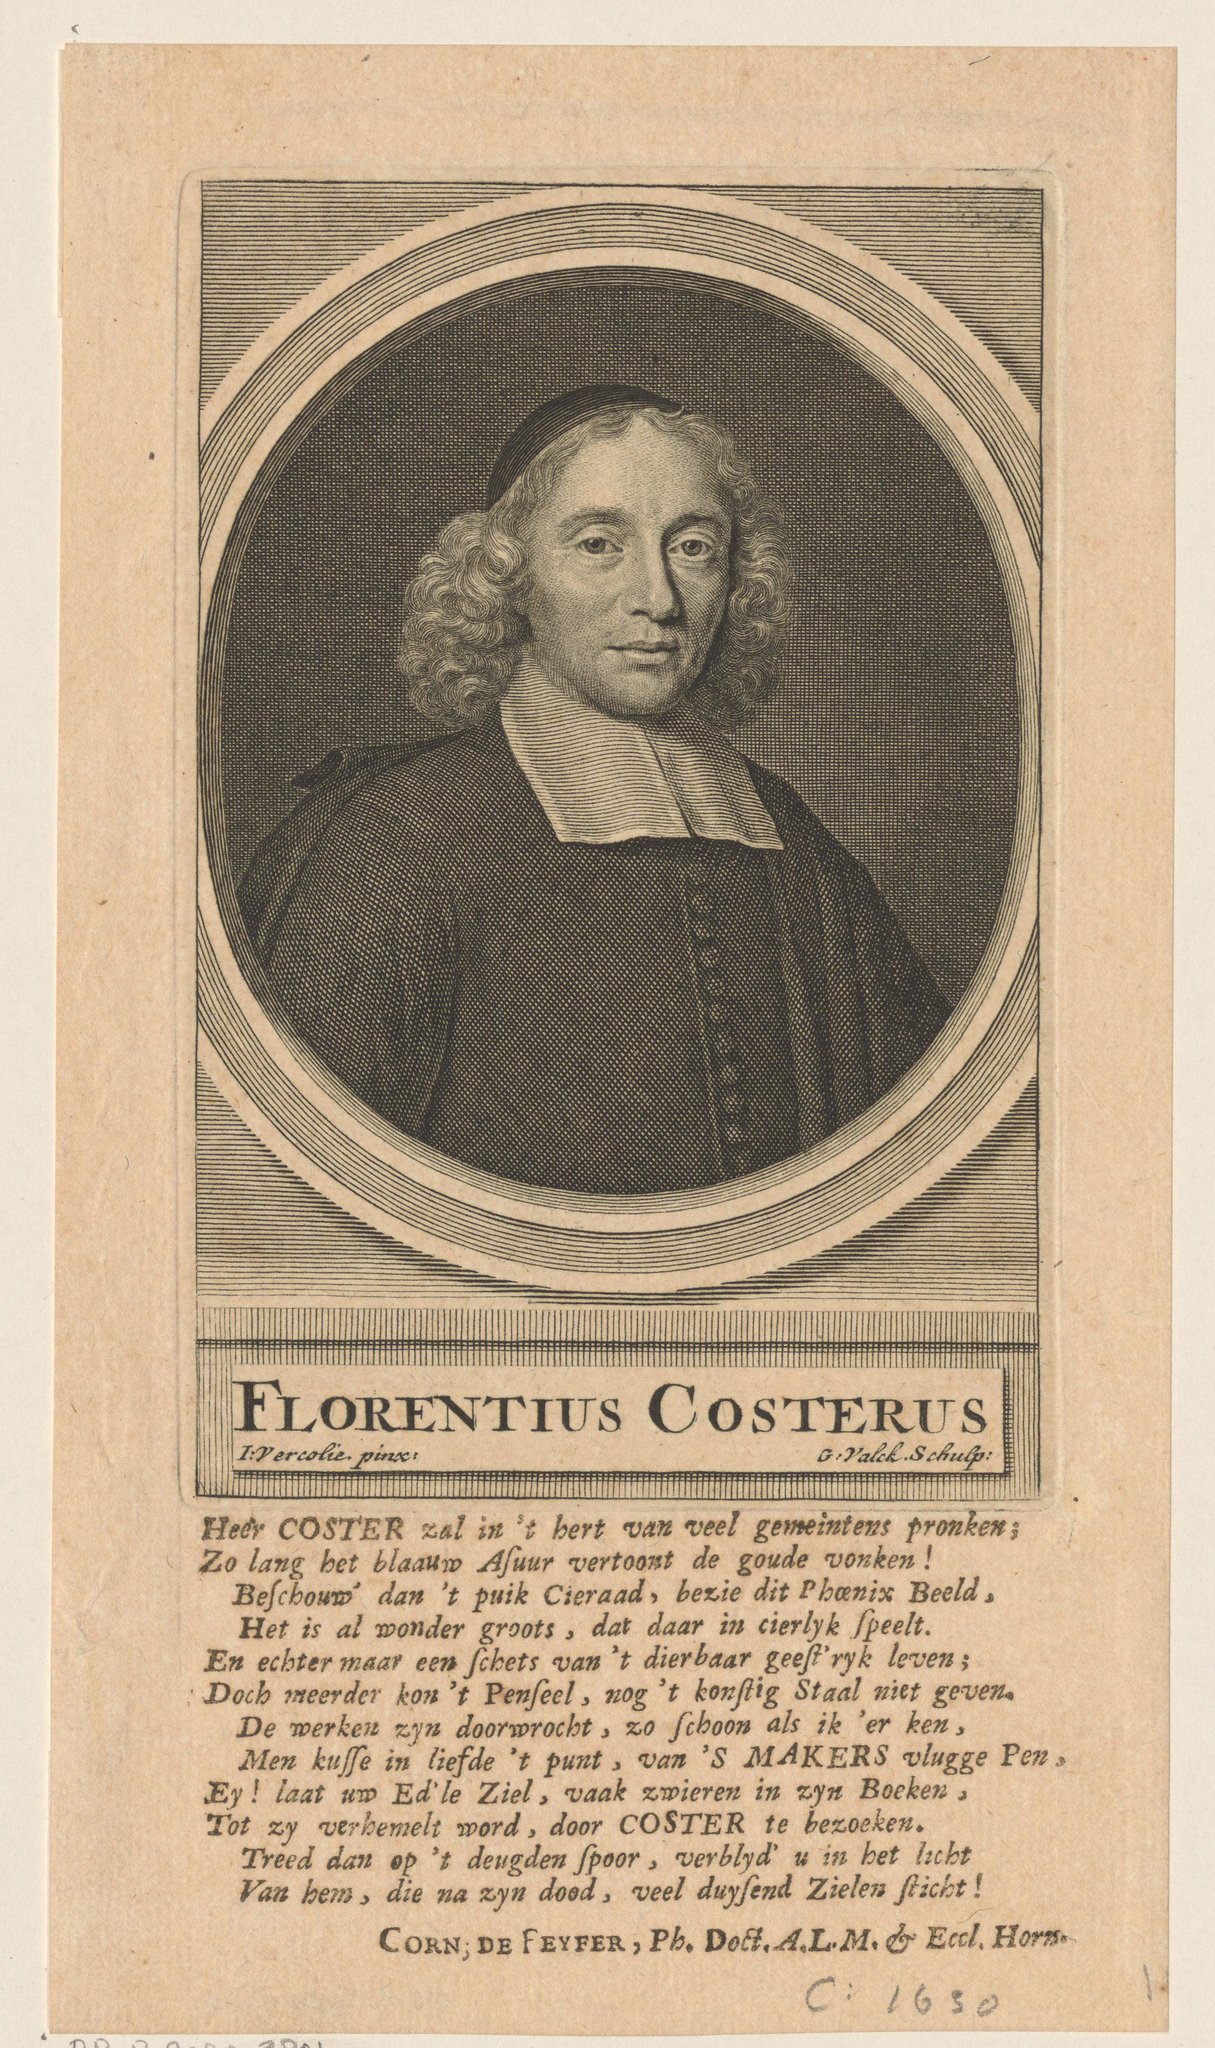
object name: print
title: Portret van Florentius Costerus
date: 1710-1780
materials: paper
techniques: engraving, letterpress printing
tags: hoorn (north holland), historical persons, study; 'studiolo'; library, the bible as a book